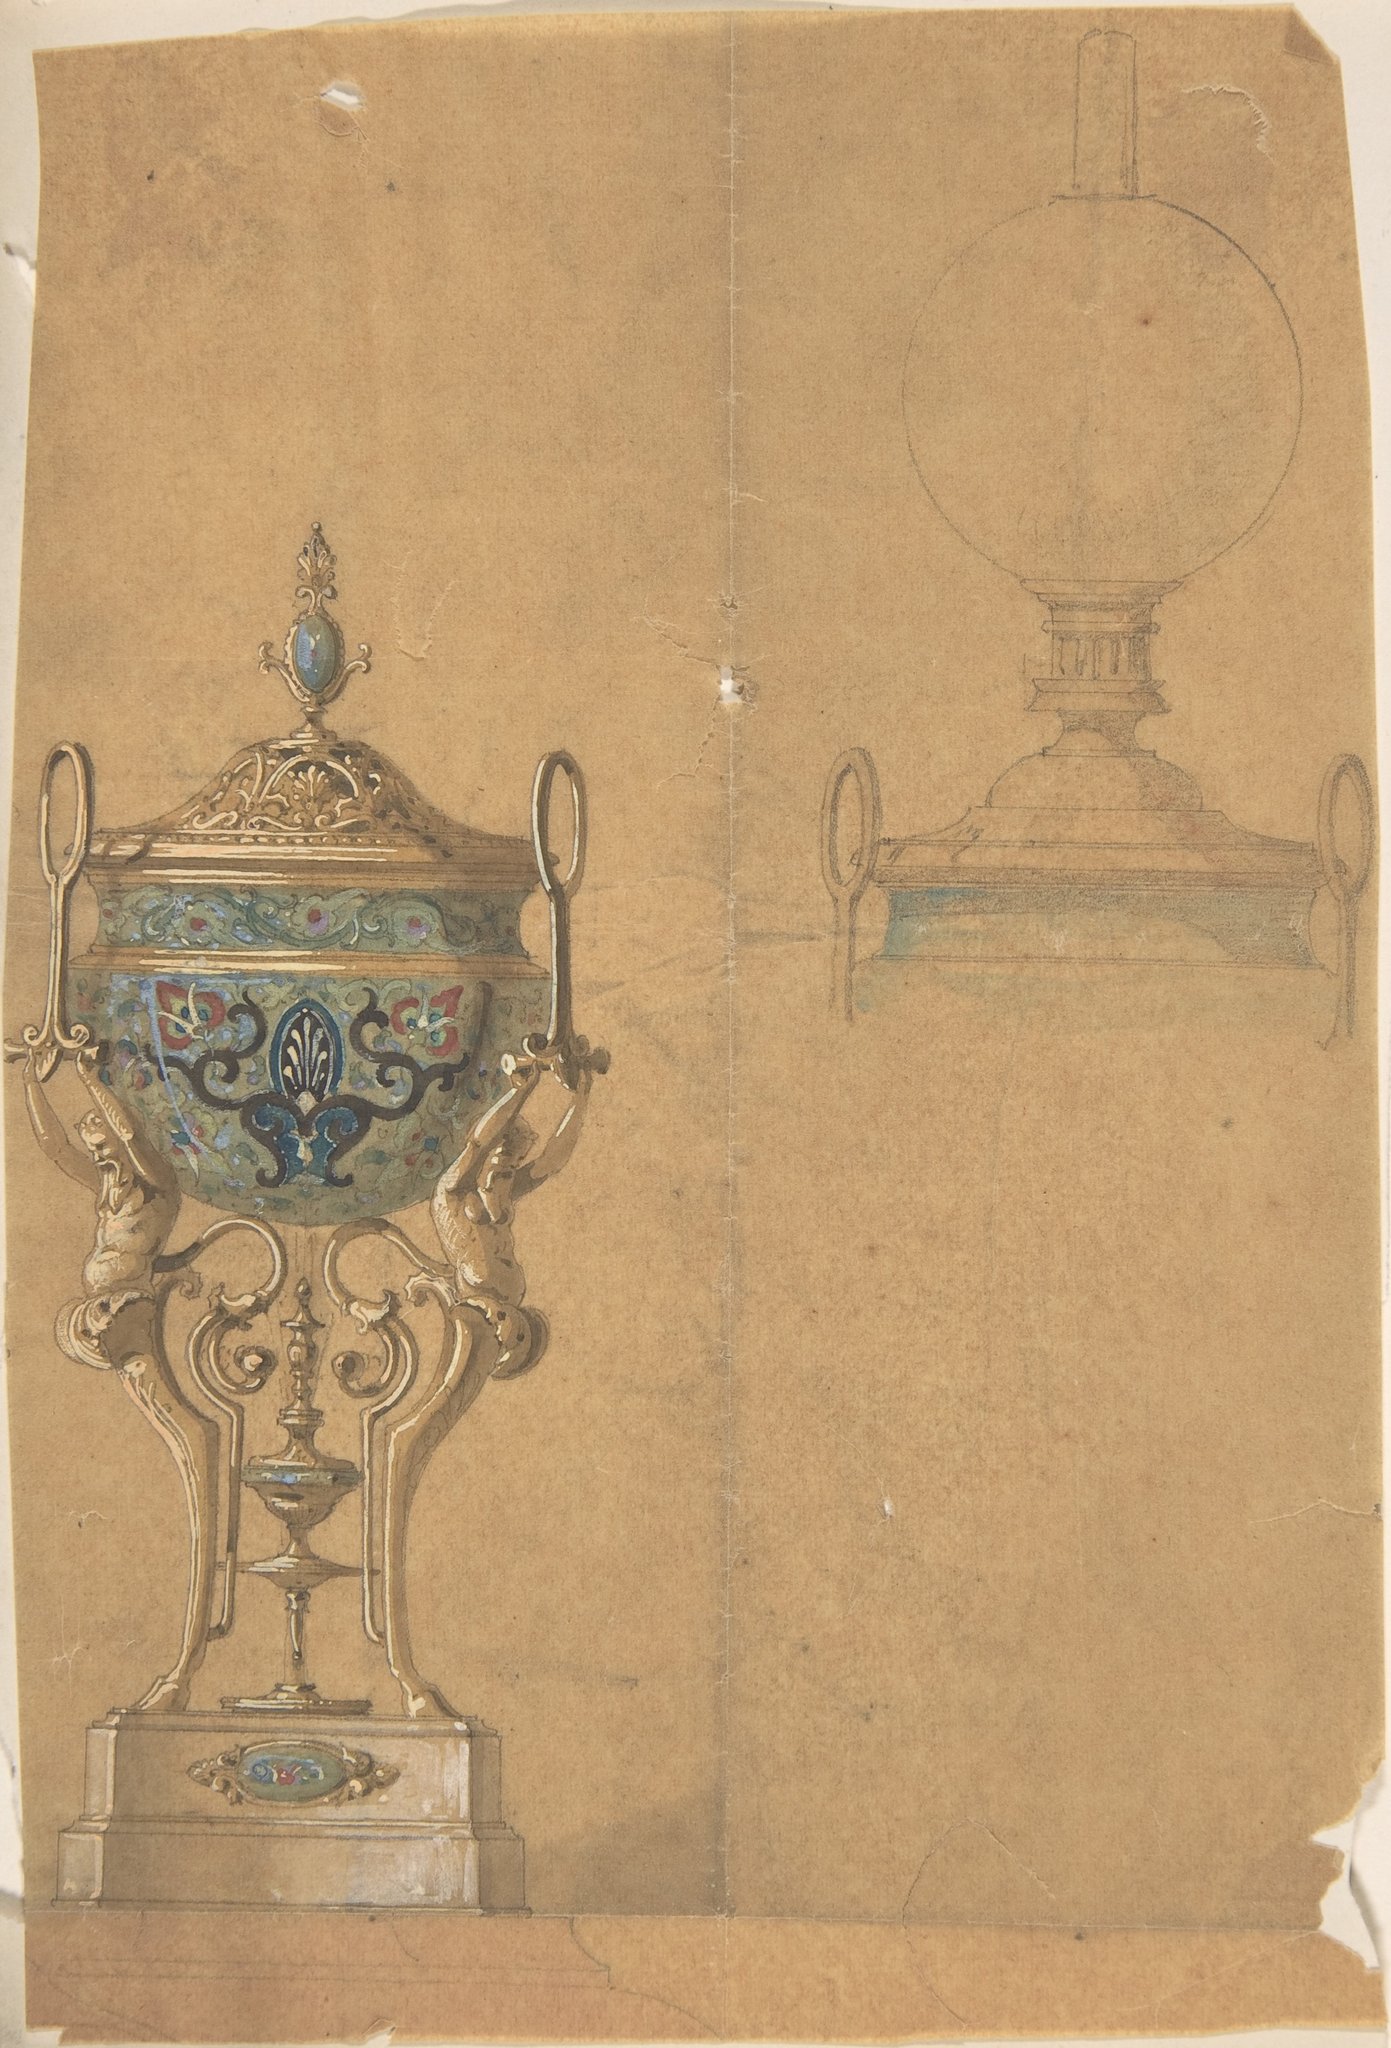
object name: drawing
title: Stone Vessel Supported on Legs in the Form of Fauns, with a Metal Lid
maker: anonymous, british, 19th century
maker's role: artist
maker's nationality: british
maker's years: 1800-1900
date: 1851-1900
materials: ink, watercolor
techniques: pen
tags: fauns,vessels